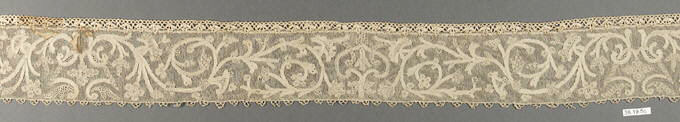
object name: hebrew ritual lace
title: Hebrew ritual lace (one of four)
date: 1701-1733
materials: silk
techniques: lace